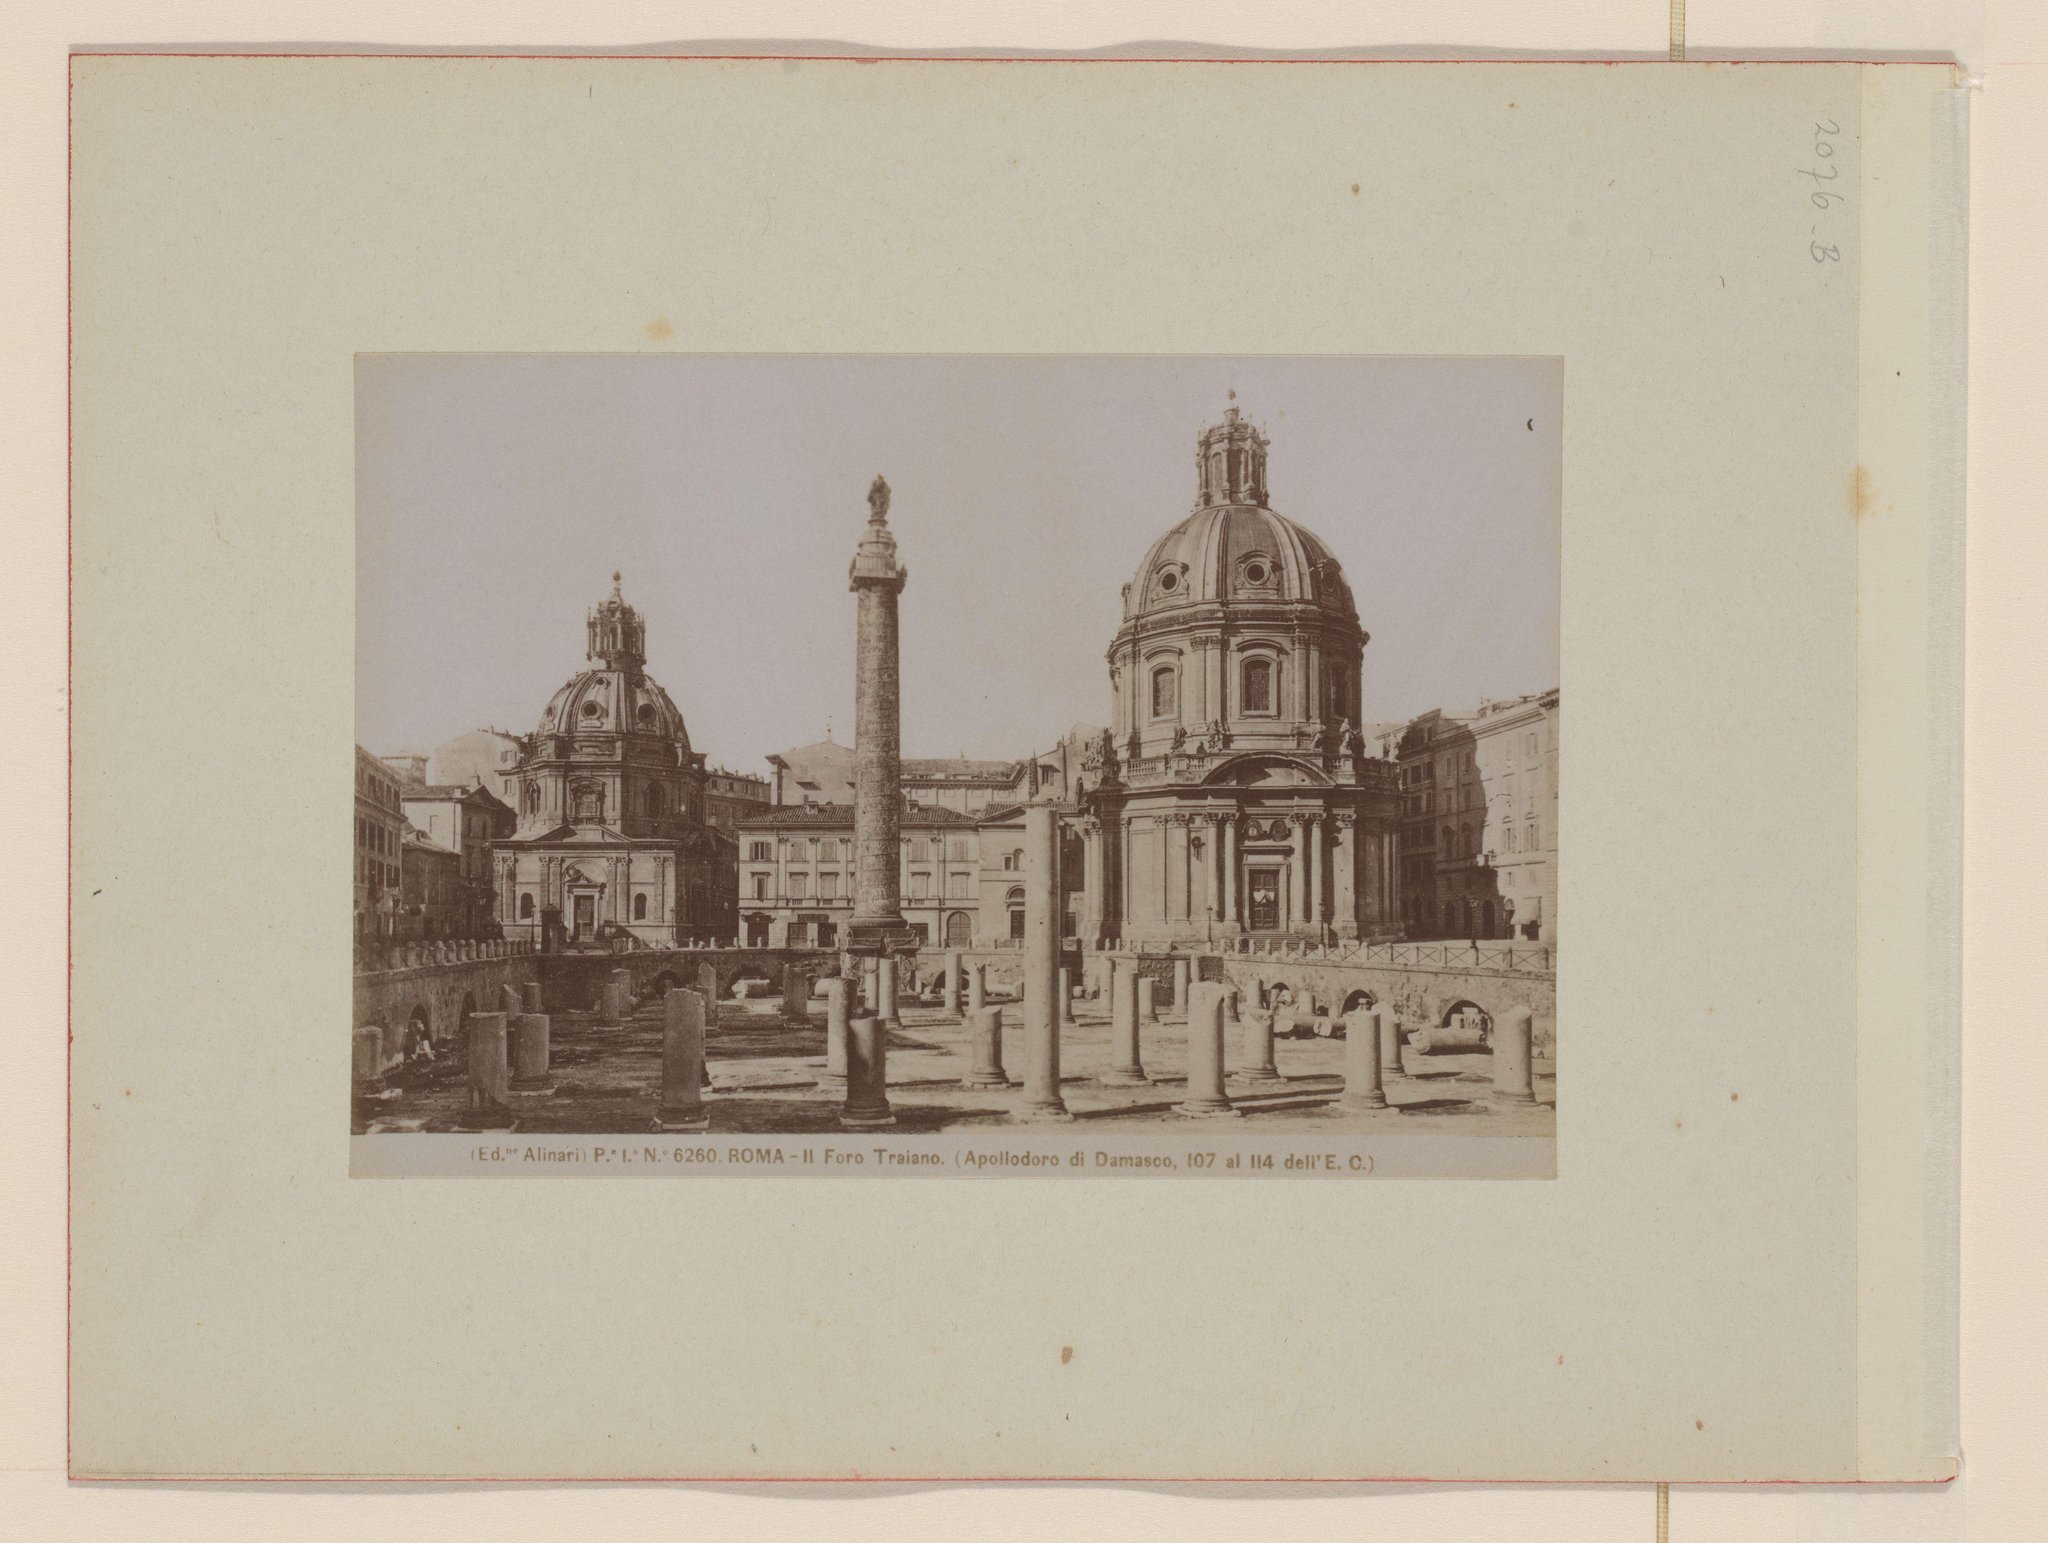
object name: photograph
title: Il Foro Traiano (Apollodoro in Damasco,107 al 114 dell' E.C.)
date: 1857-1900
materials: cardboard, paper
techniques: albumen print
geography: florence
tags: court building, landscape with ruins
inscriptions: number: ‘Po.Io.No. 6260.’